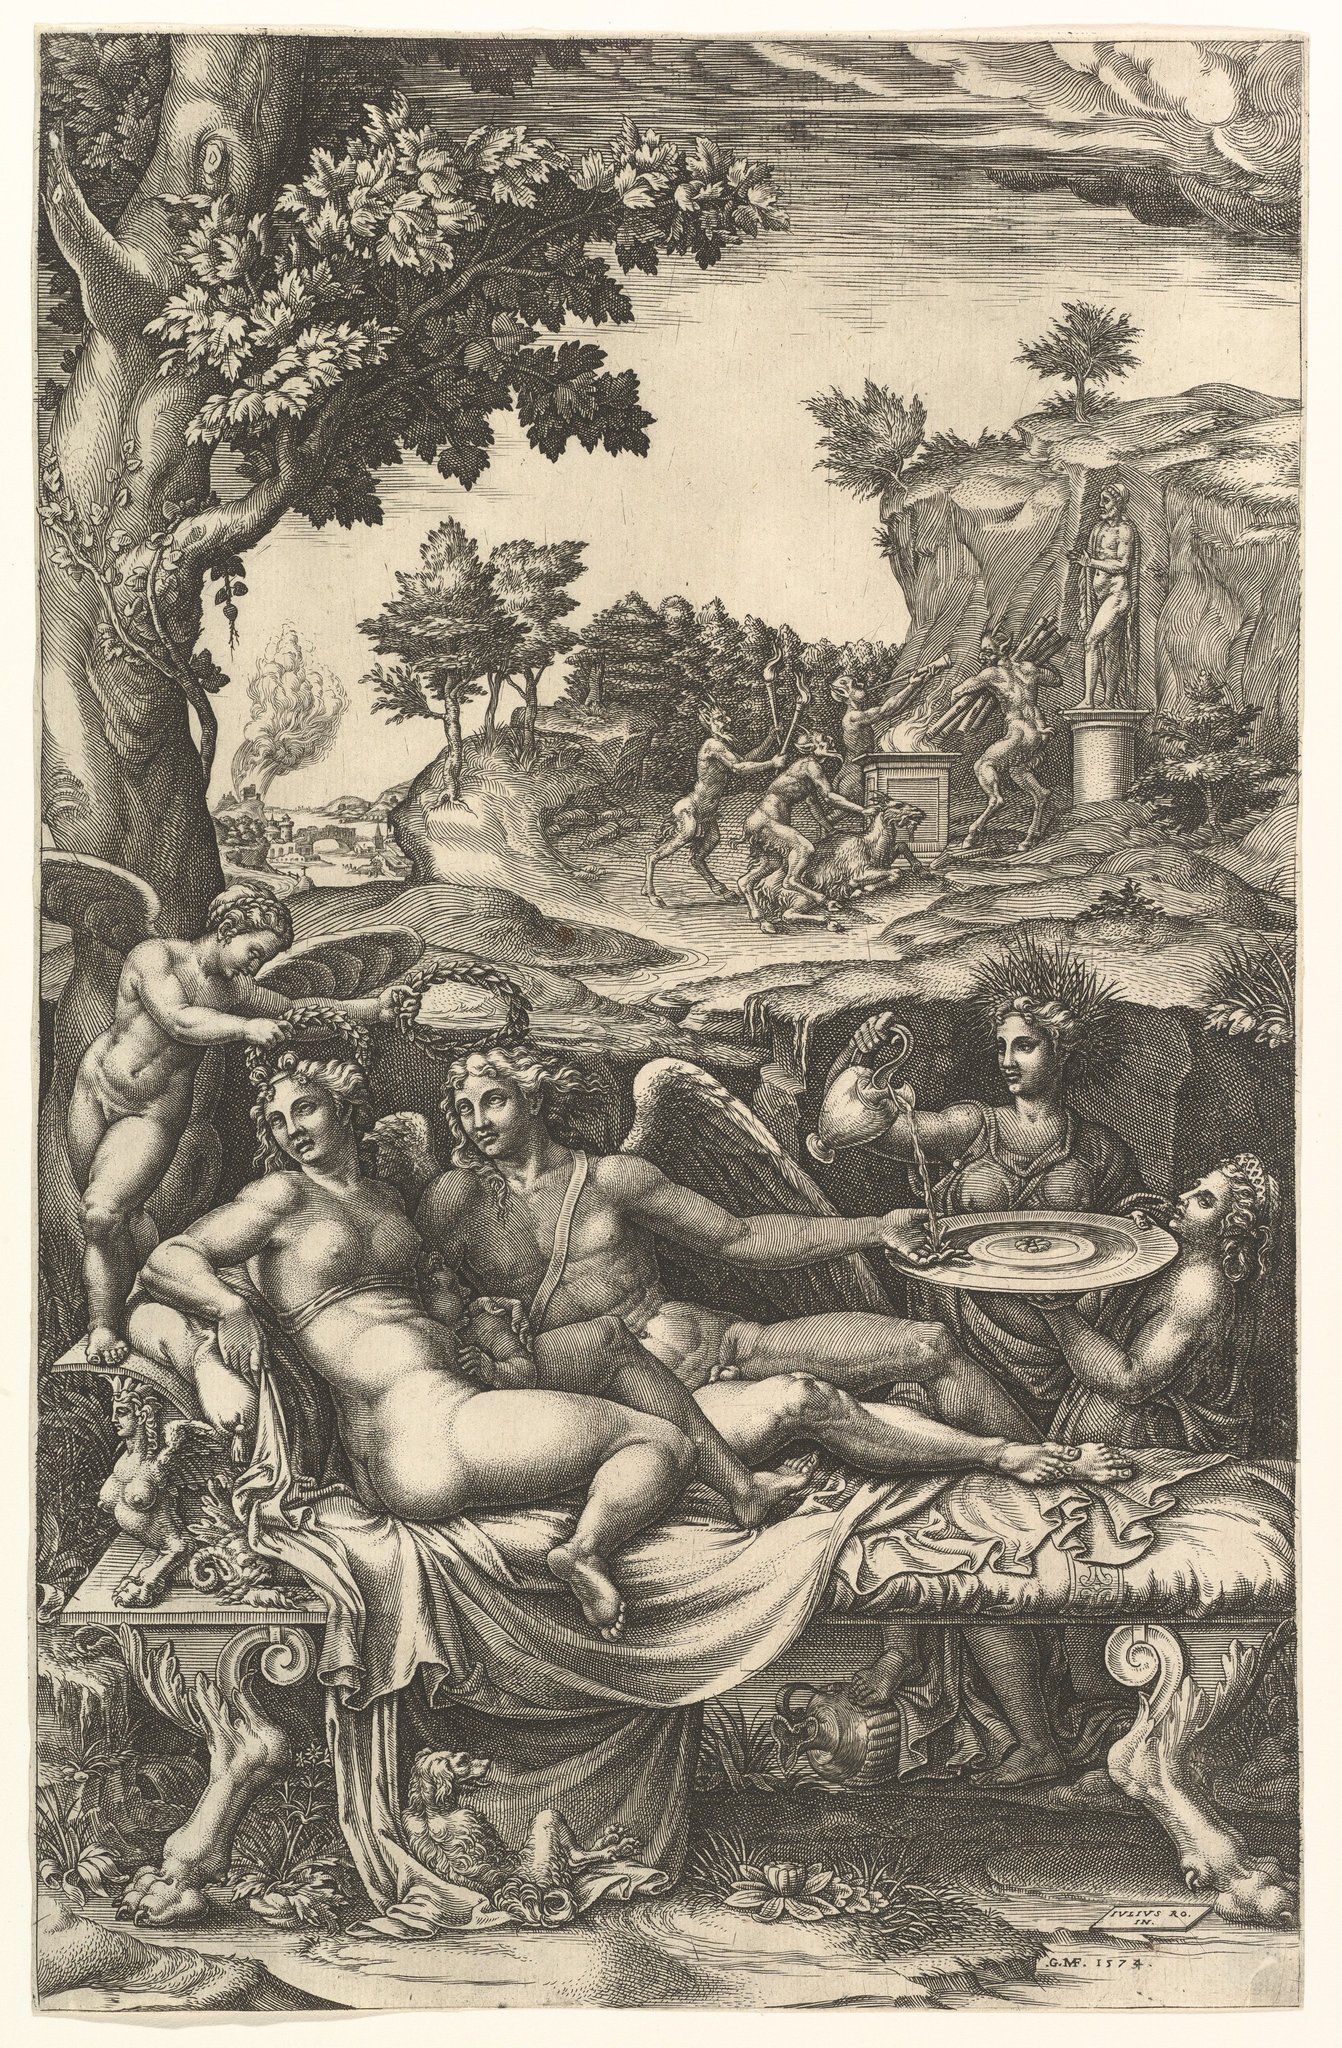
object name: print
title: Cupid and Psyche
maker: giorgio ghisi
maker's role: artist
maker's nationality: italian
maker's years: 1515-1582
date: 1573-1574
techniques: engraving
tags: cupid,psyche